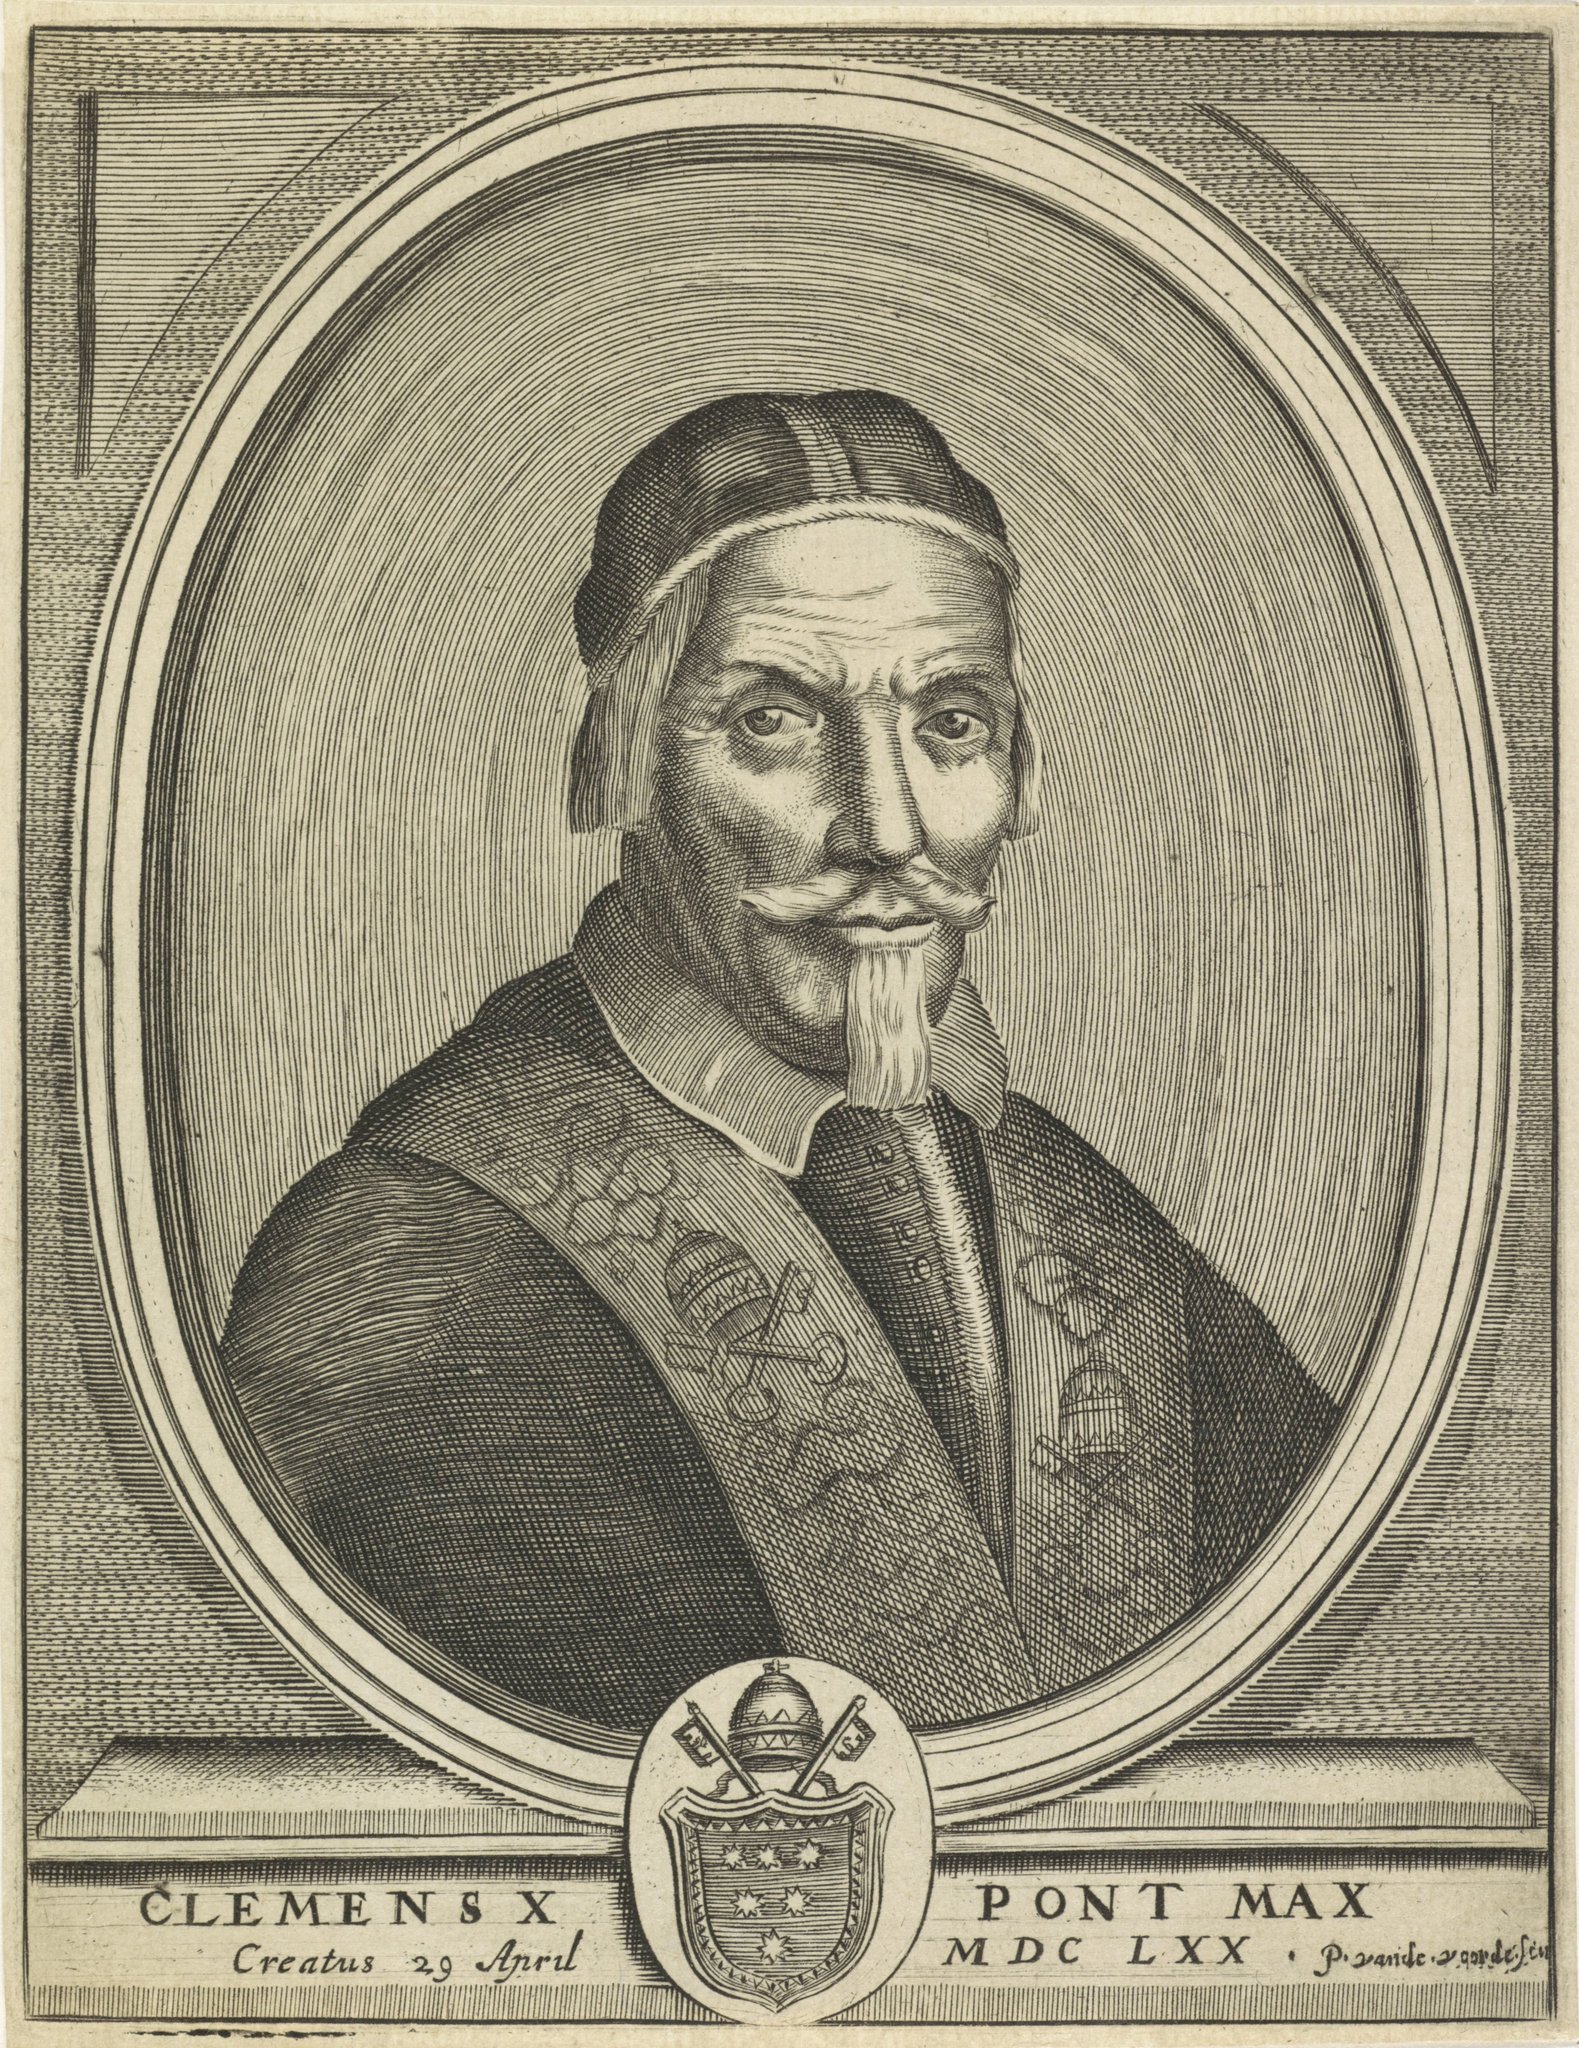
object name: print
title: Portret van paus Clemens X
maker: peter van voorde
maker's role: print maker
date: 1670-1671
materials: paper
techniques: engraving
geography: northern netherlands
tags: clemens x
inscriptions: collector's mark: Lugt 2228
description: Prent ook gebruikt als boekillustratie in: Hollandtsche Mercurius, vervaetende de voornaemste gheschiedenissen, voorgevallen niet alleen in christenryck, maer oock in Asia, Africa en America, binnen het jaer 1670. : Het XXI. deel. Haarlem: Pieter Casteleyn, 1671.